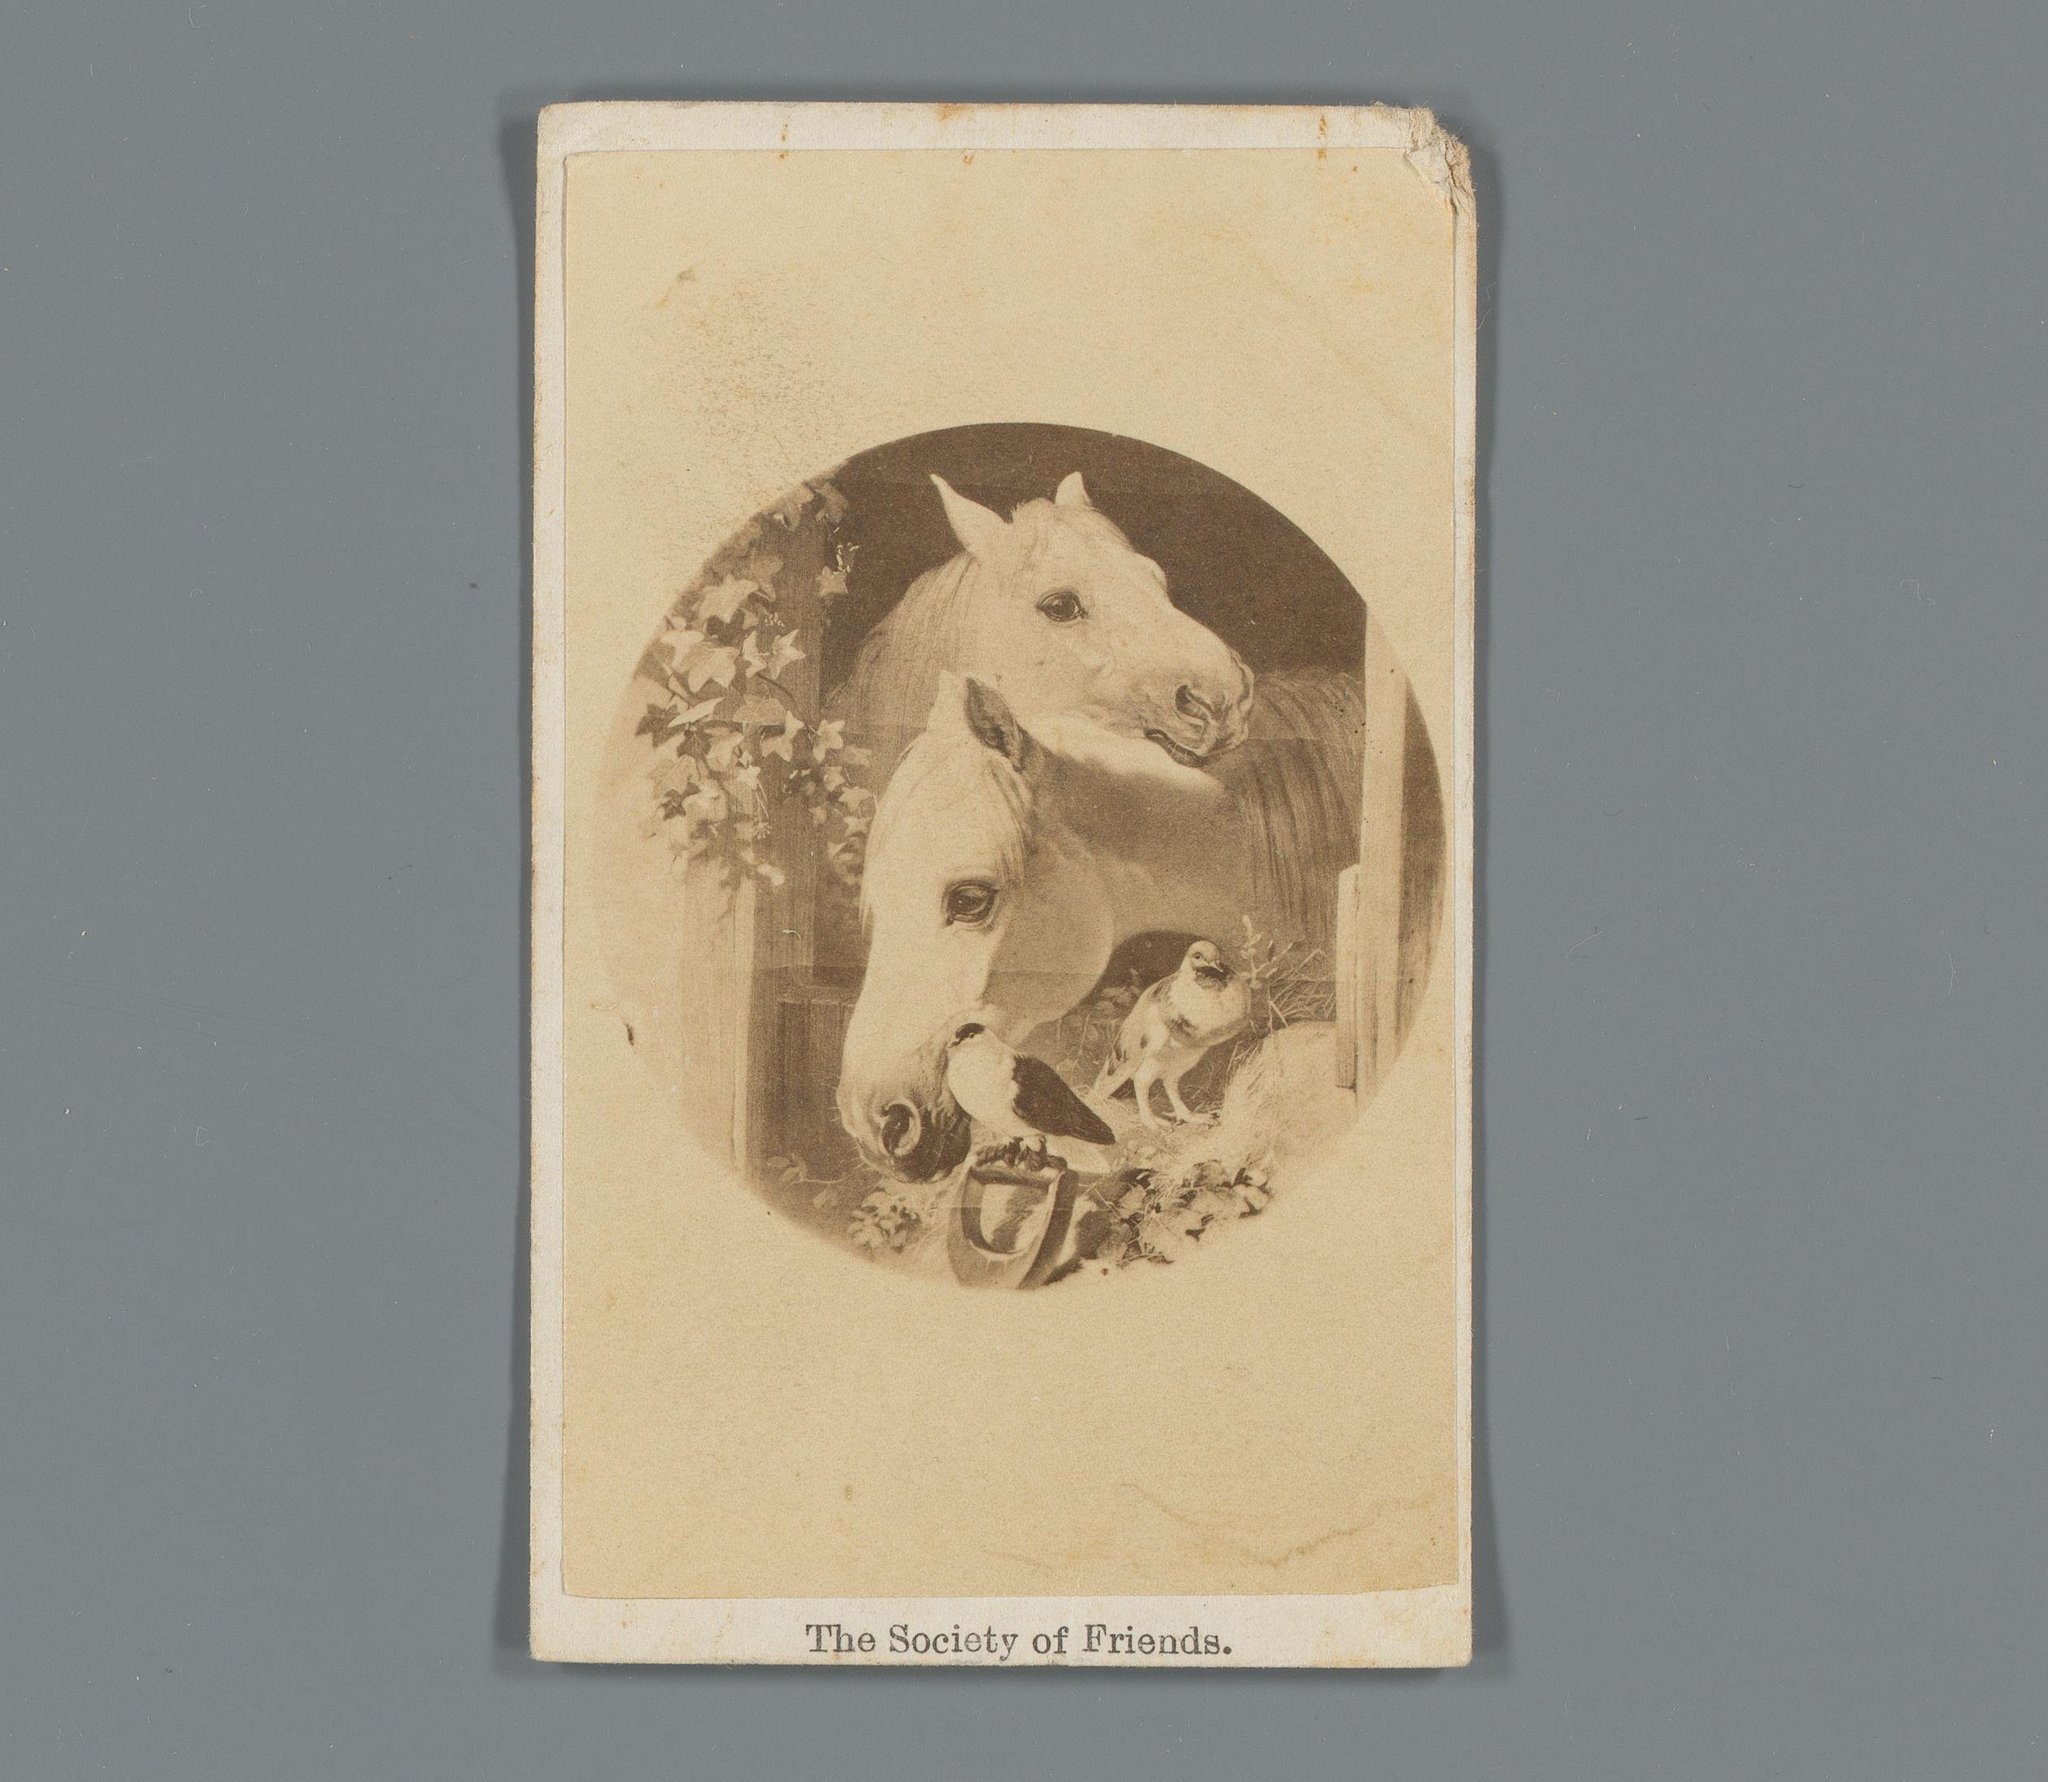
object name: reproduction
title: The society of friends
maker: Anonymous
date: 1850-1915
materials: cardboard, photographic support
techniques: albumen print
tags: advertising, birds, horse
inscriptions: inscription: ‘Photograph Novelty./ We sell you a Card Photograph and any article selected by the/ (...)/ PLEASE EXAMINE OUR GOODS/ In Departments from/ A to C’